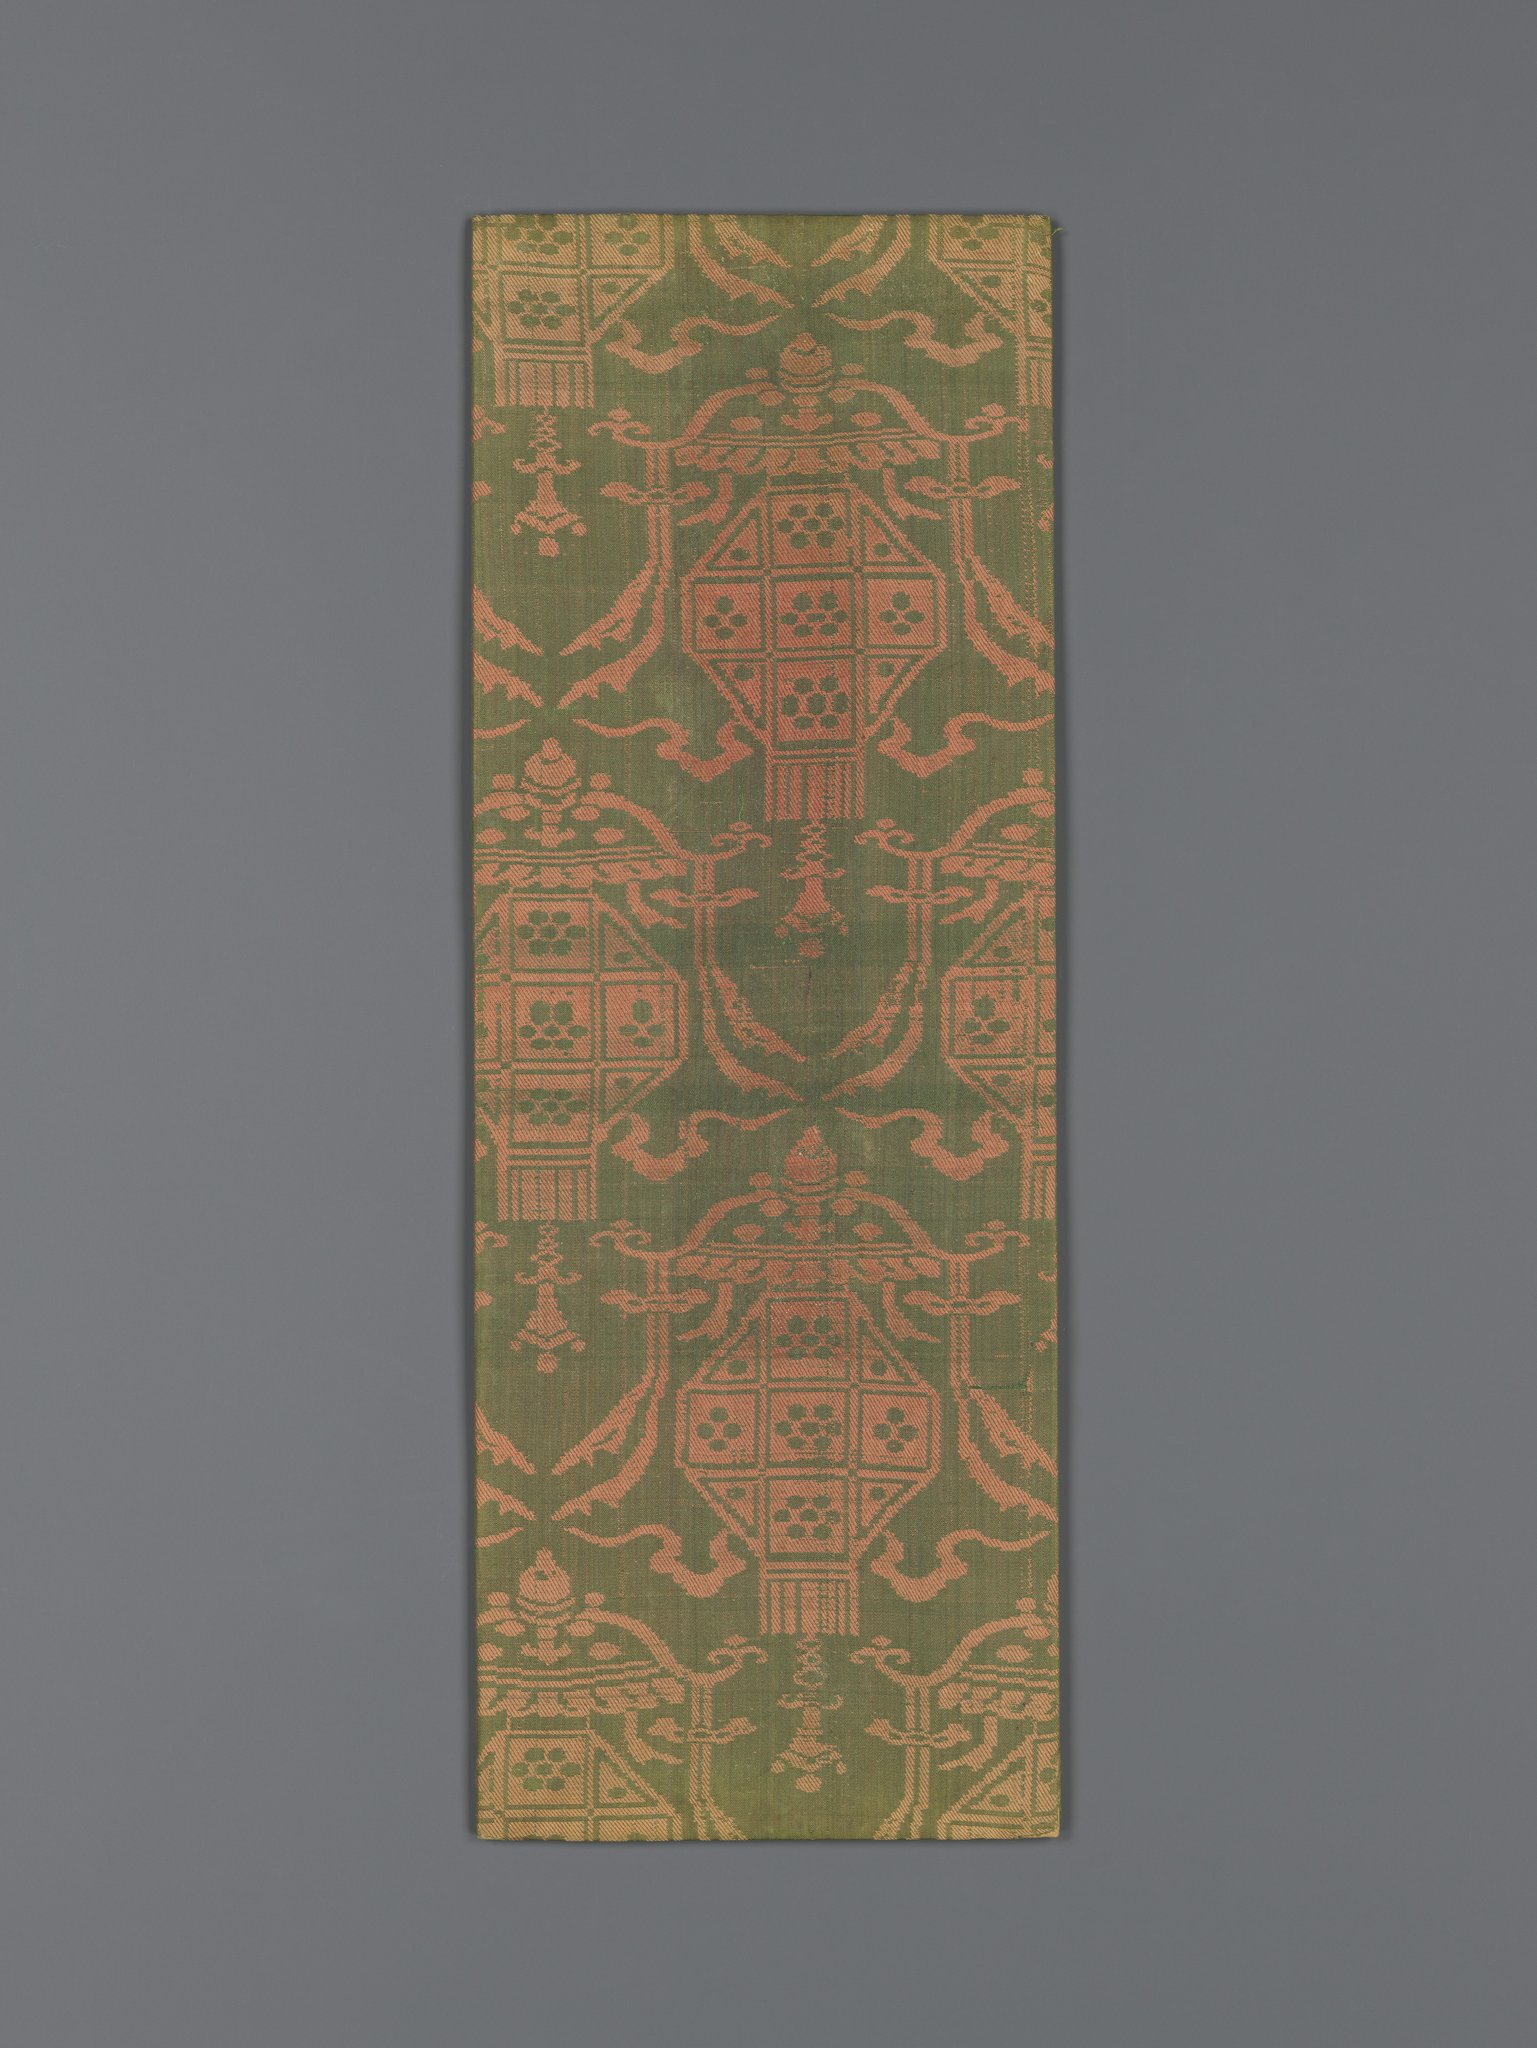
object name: sutra cover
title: Sutra Cover with Pattern of Hanging Lanterns with Ribbons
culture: chinese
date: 1501-1600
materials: silk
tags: lanterns